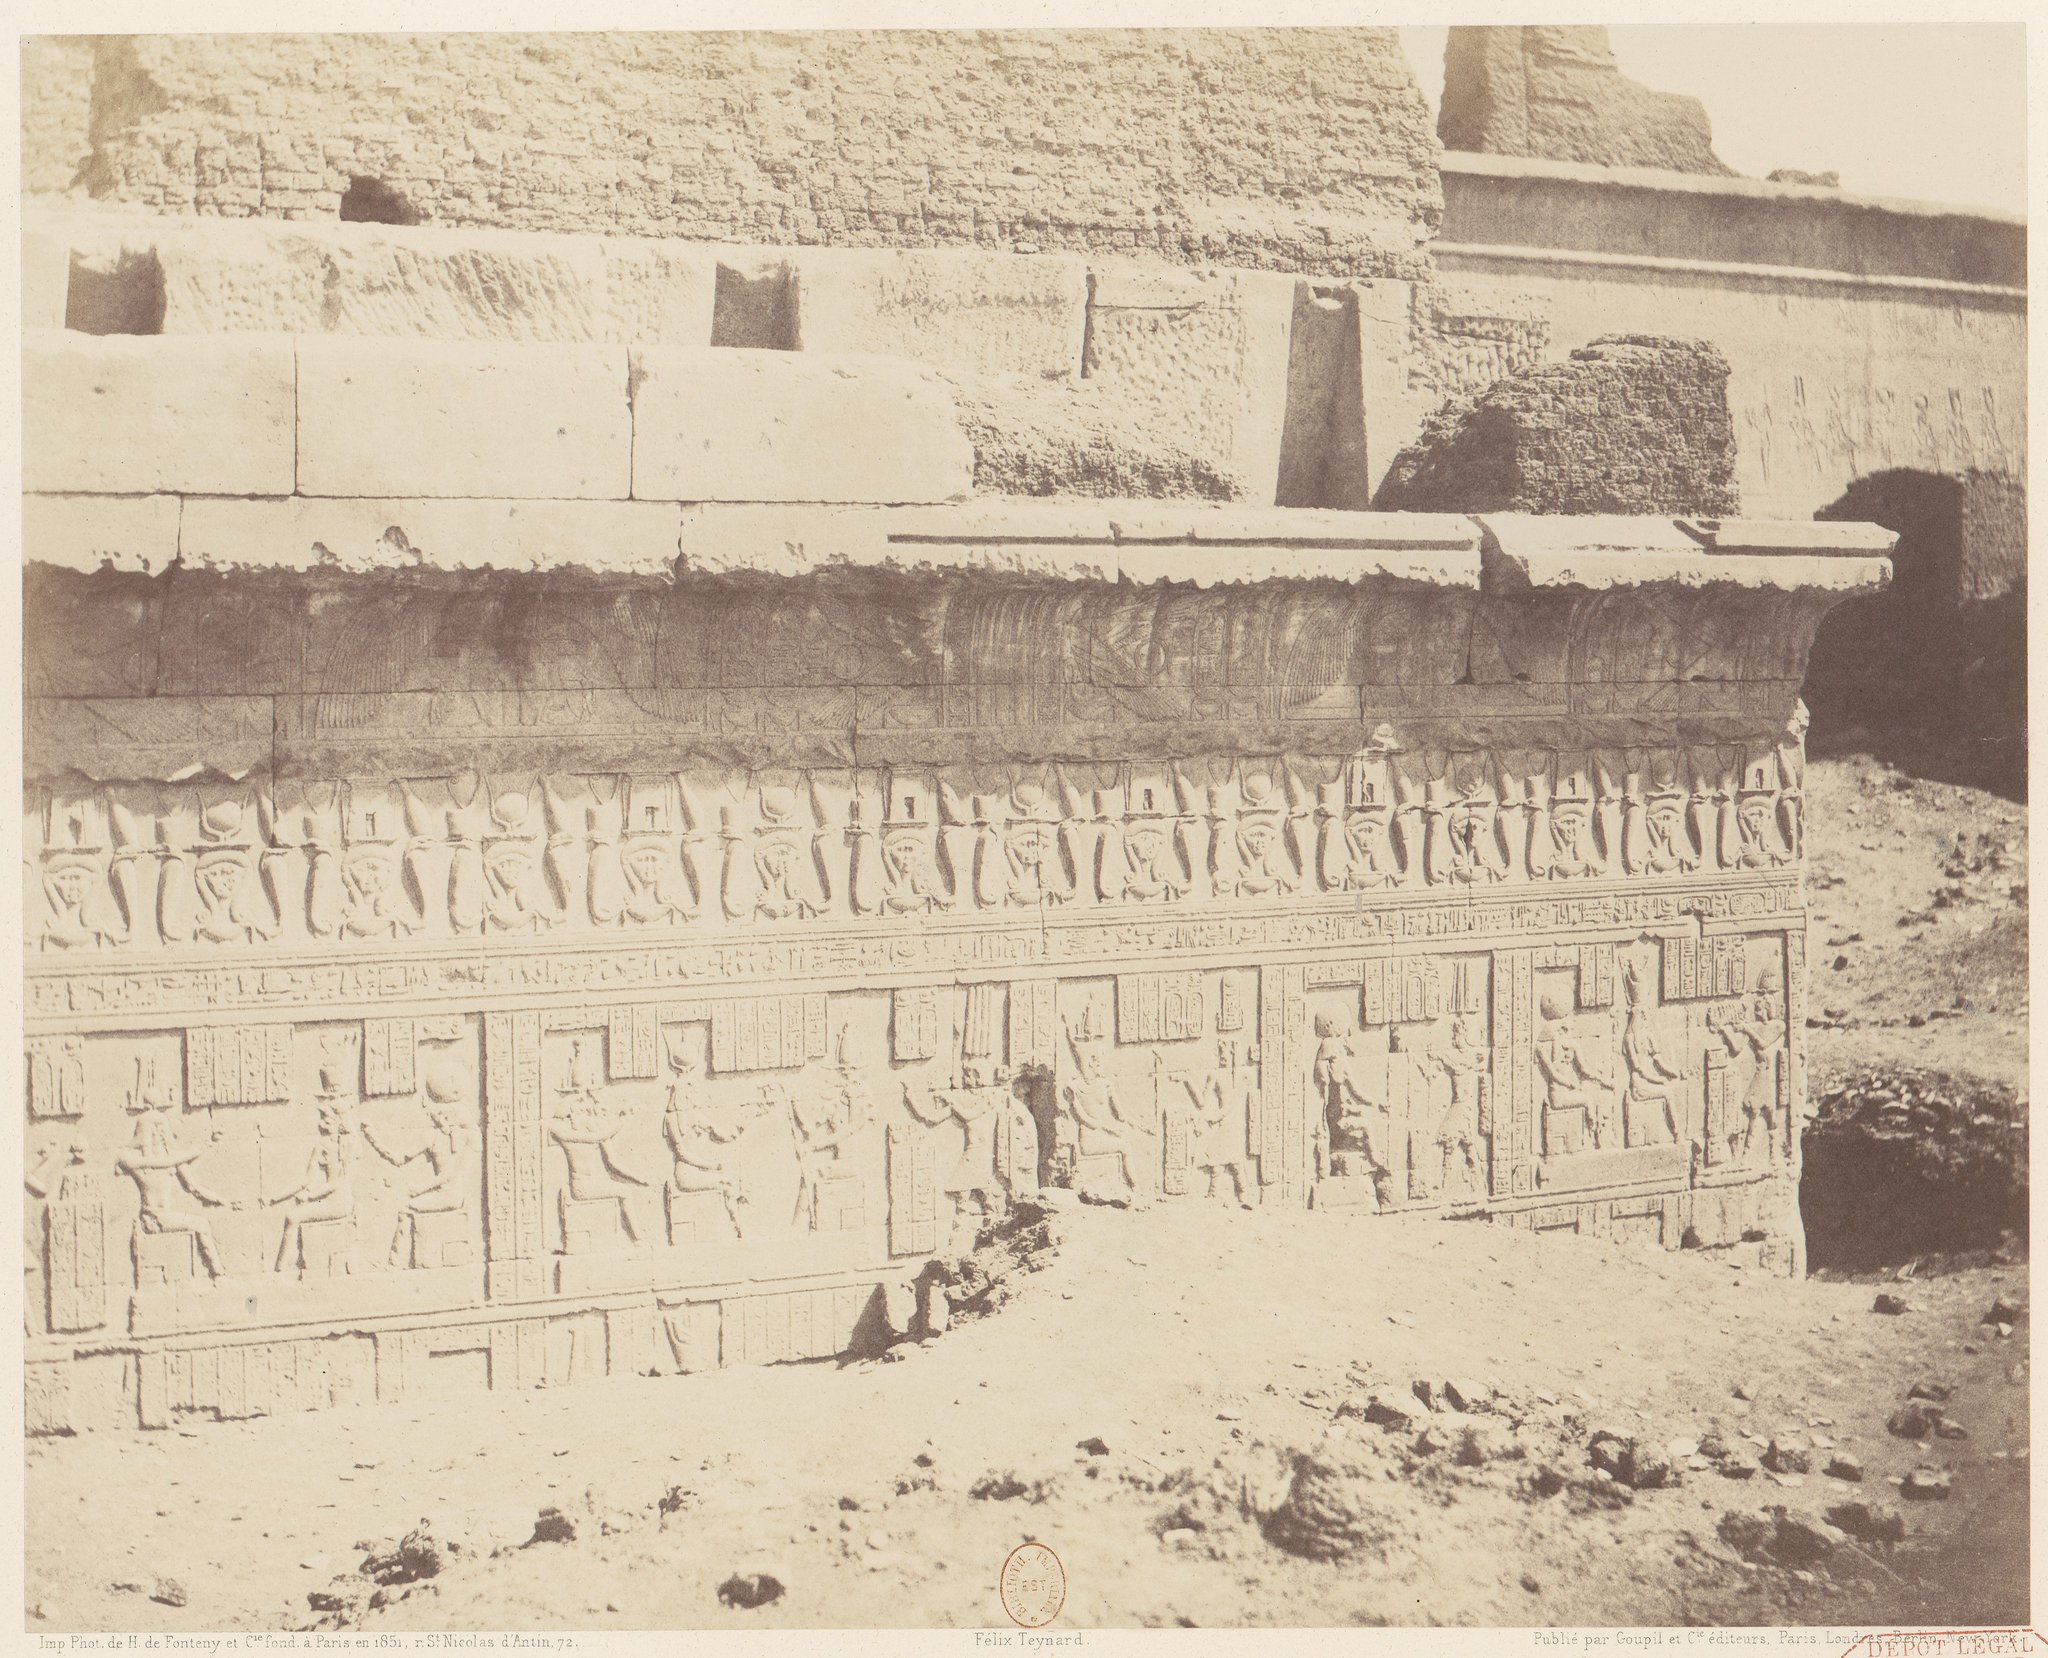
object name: photograph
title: Dendérah (Tentyris), Mammisi - Décoration Extérieure de la Face Sud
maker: félix teynard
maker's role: artist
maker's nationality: french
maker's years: 1817-1892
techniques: paper negative, salted paper print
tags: architecture,ruins